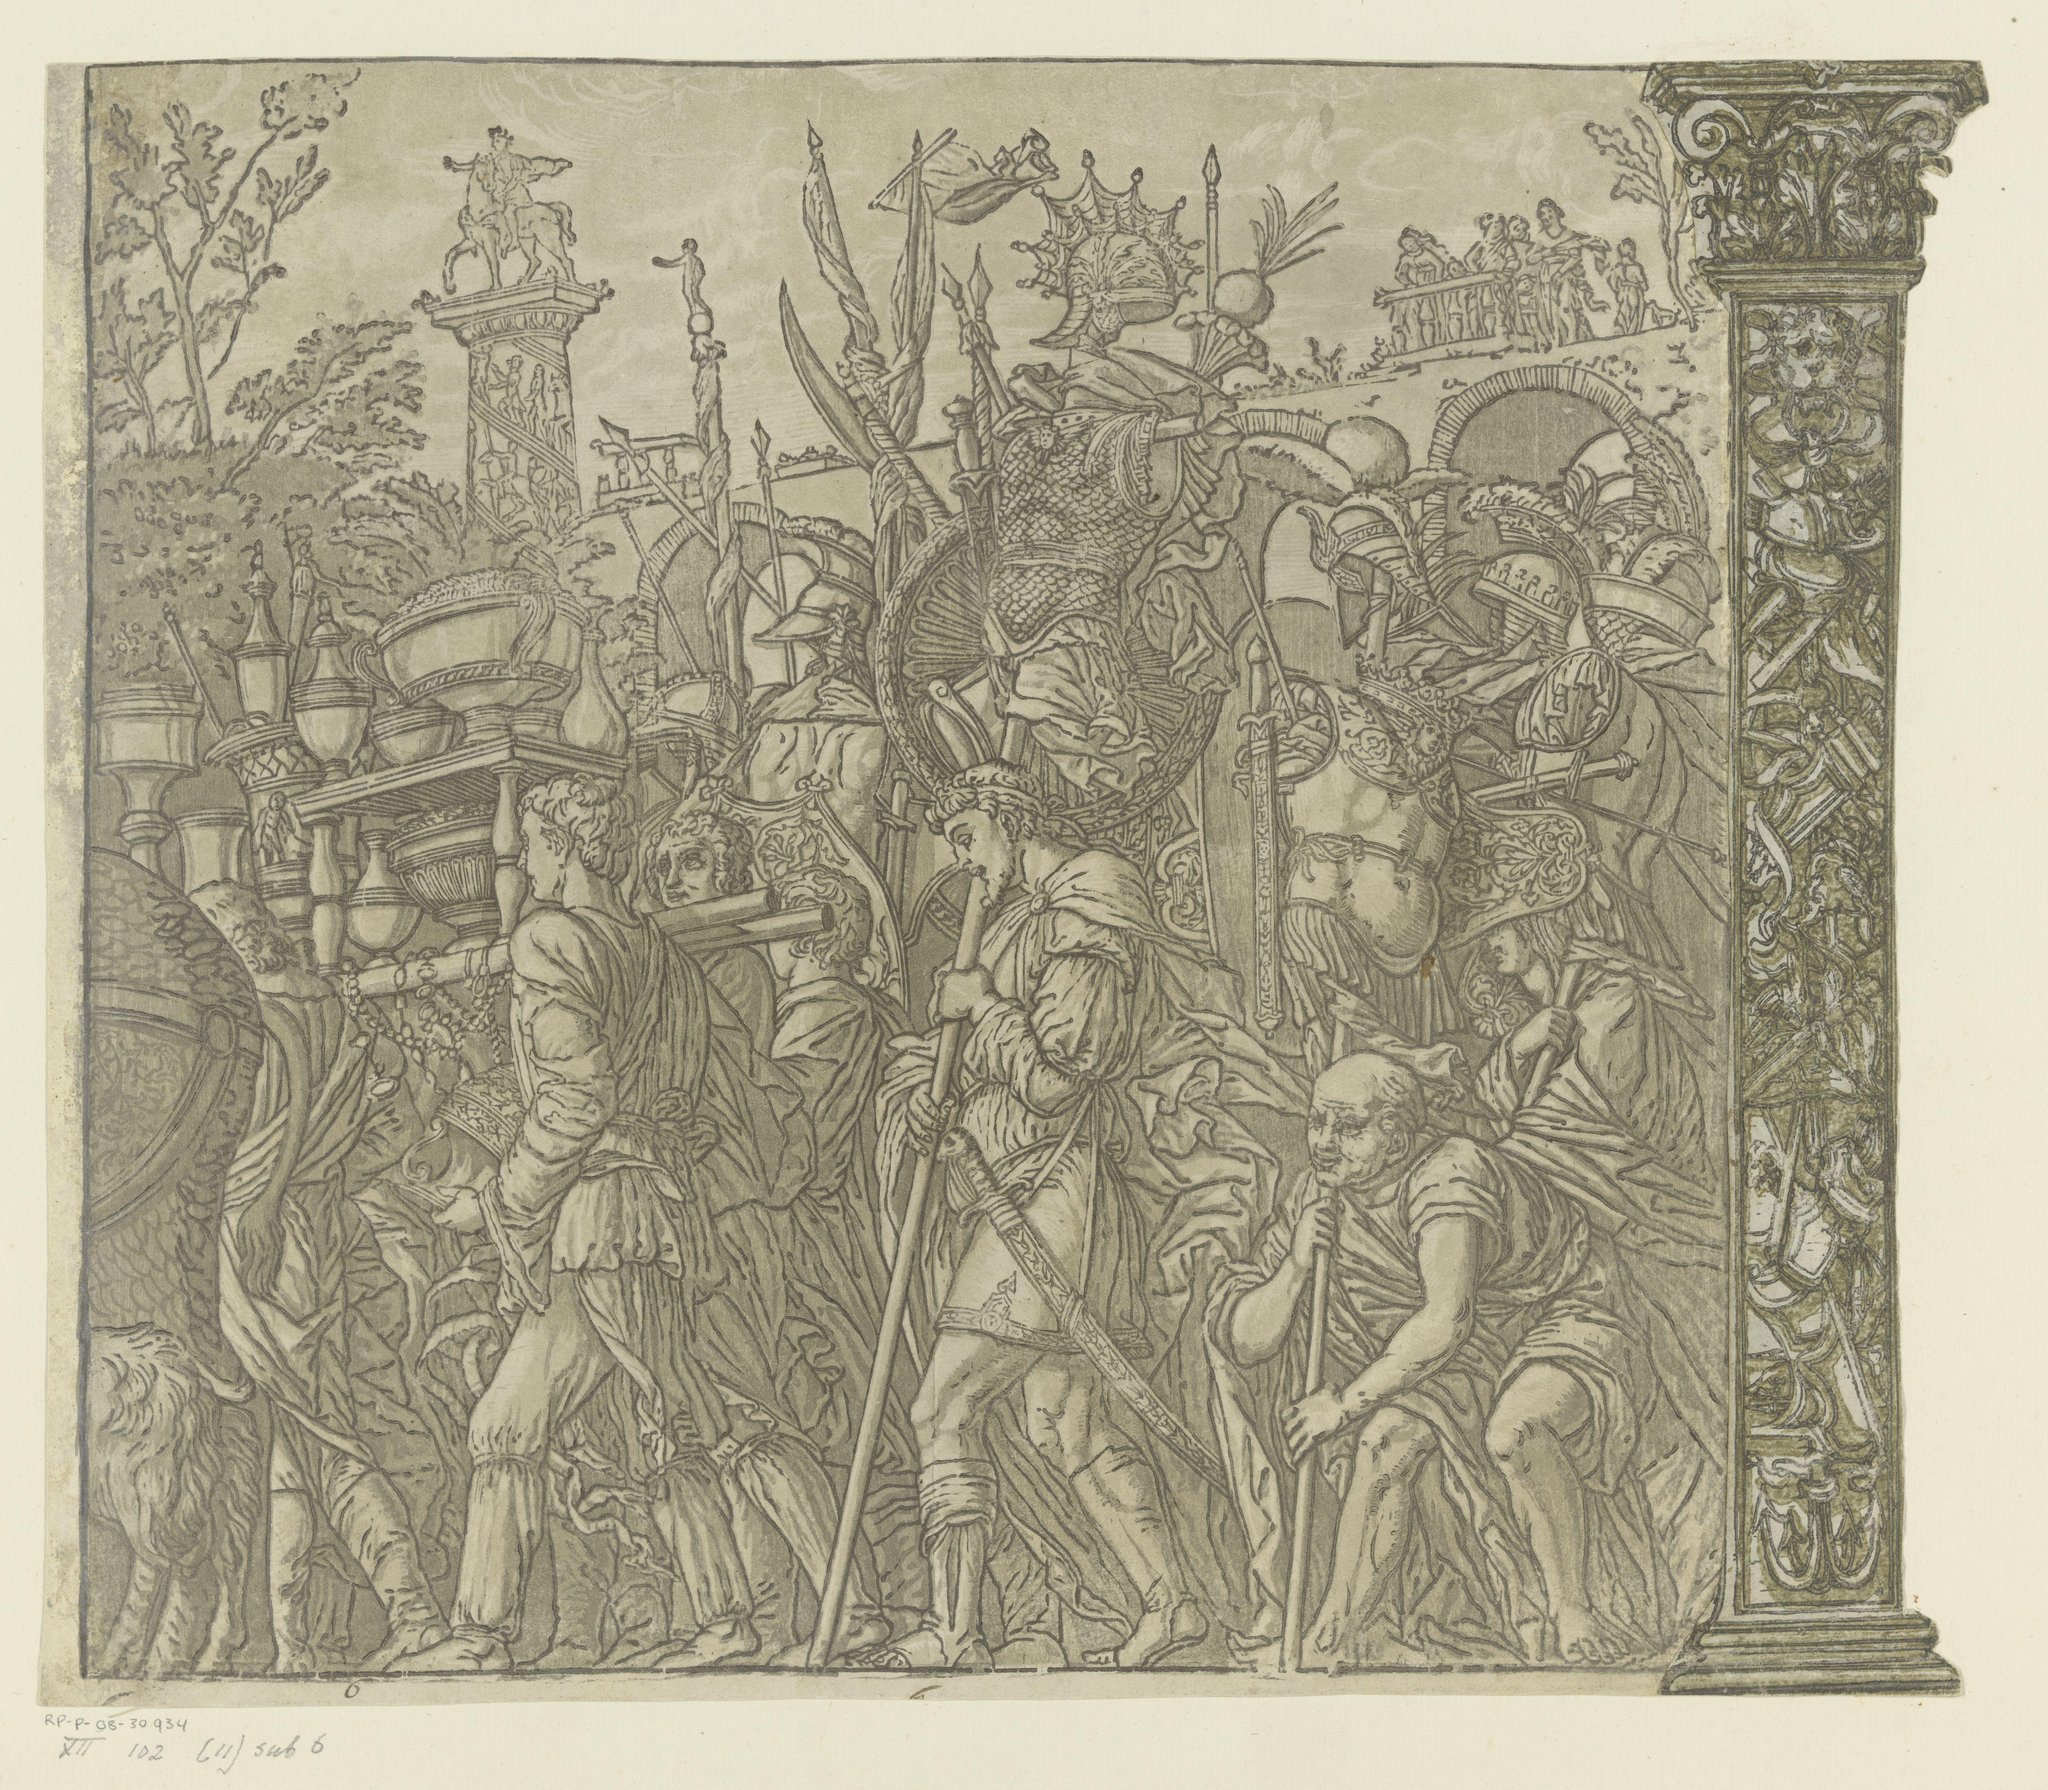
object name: print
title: Triomftocht van Julius Caesar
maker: andrea andreani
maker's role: print maker, printer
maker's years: 1558-1629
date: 1599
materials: paper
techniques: woodcut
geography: mantua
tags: armour, triumph of caesar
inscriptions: collector's mark: Lugt 240, number: ‘6’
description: Deze prent maakt deel uit van een fries dat bestaat uit een titelprent en negen prenten die samen een triomftocht van Julius Caesar vormen. Bij de serie hoort tevens een prent met daarop zes Korinthische pilasters, bedoeld om te worden uitgeknipt en gebruikt als verbindingsstukken tussen de verschillende bladen. Op dit exemplaar is een pilaster aan de rechterkant gemonteerd. Op de achterzijde van de pilaster een afdruk van een andere clair-obscur houtsnede.